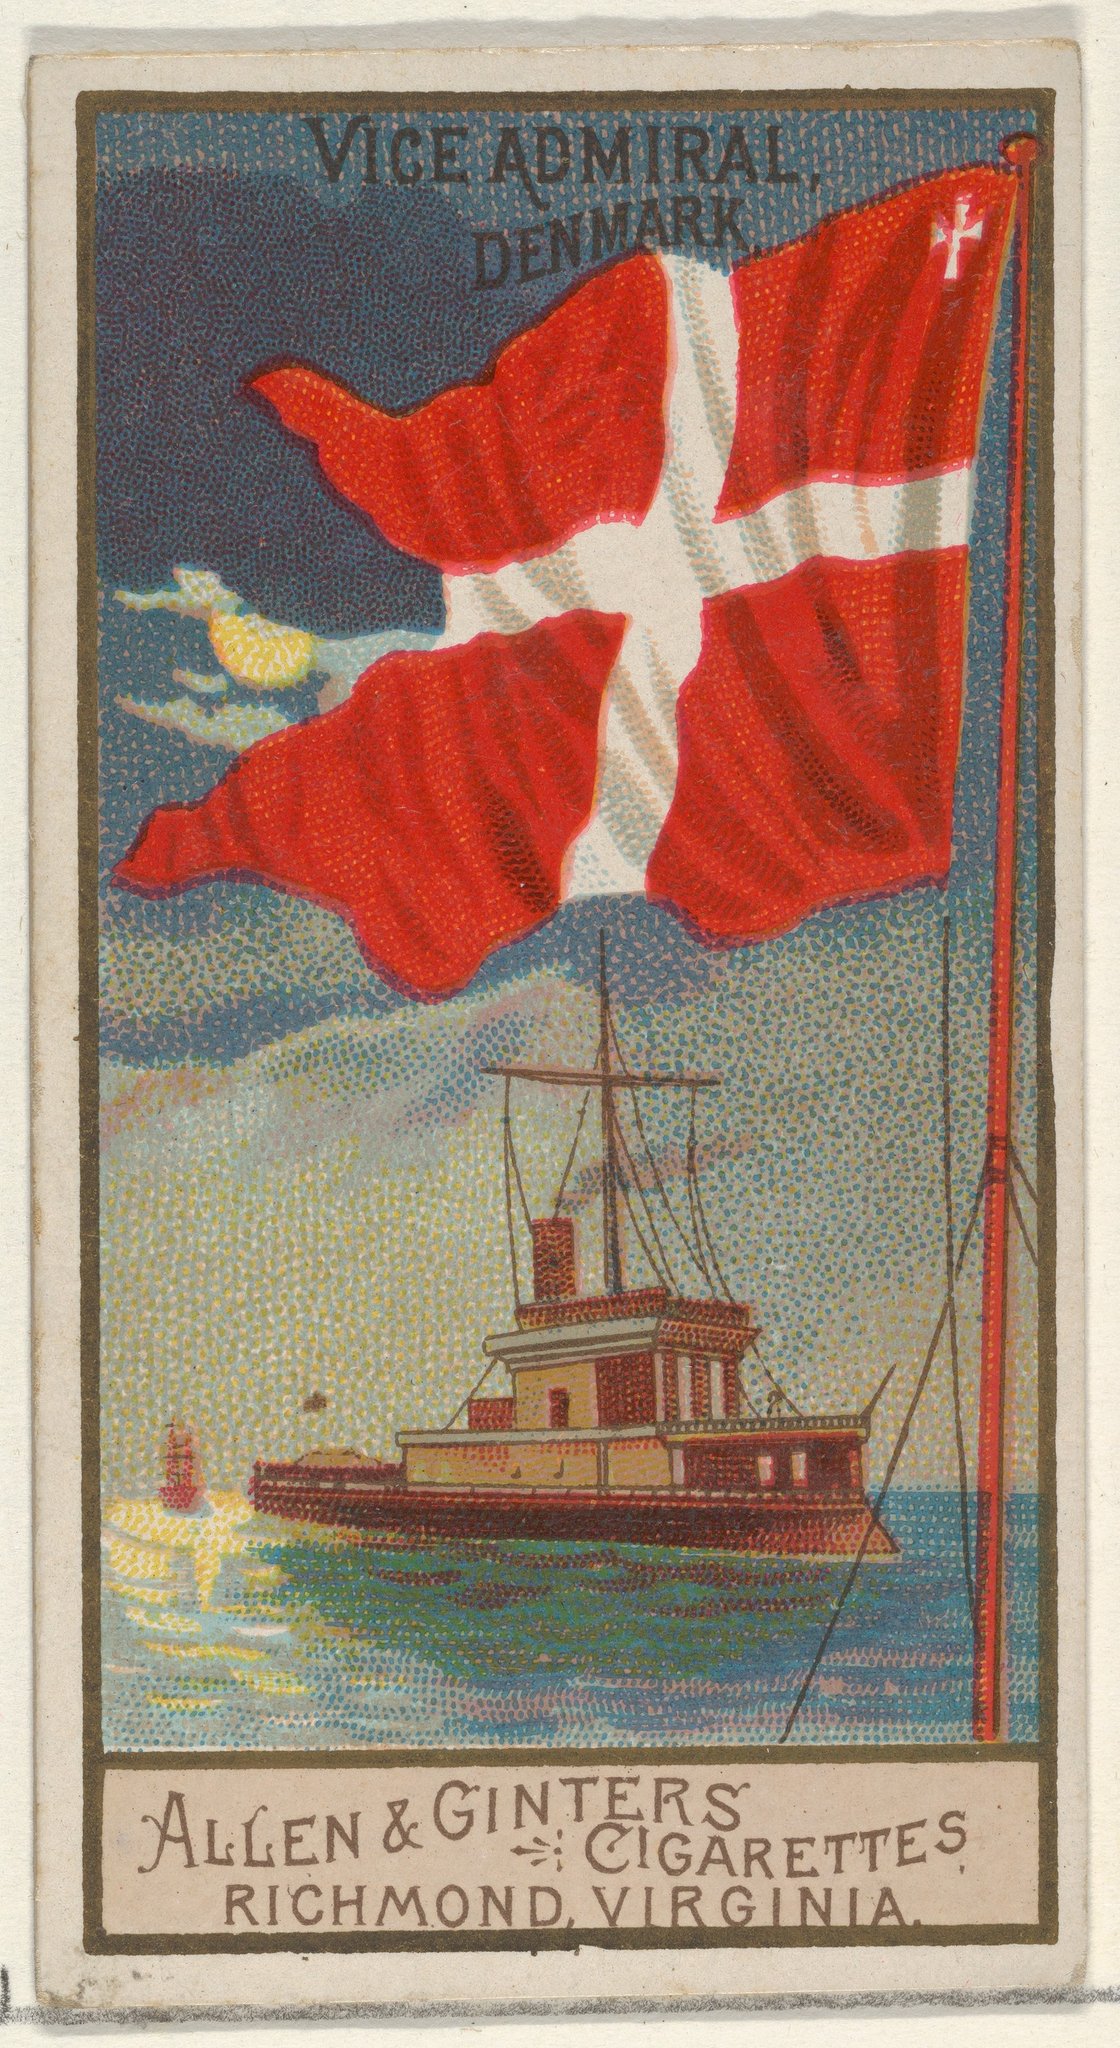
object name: print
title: Vice Admiral, Denmark, from the Naval Flags series (N17) for Allen & Ginter Cigarettes Brands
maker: allen & ginter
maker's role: publisher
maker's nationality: american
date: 1888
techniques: color lithograph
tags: flags,ships